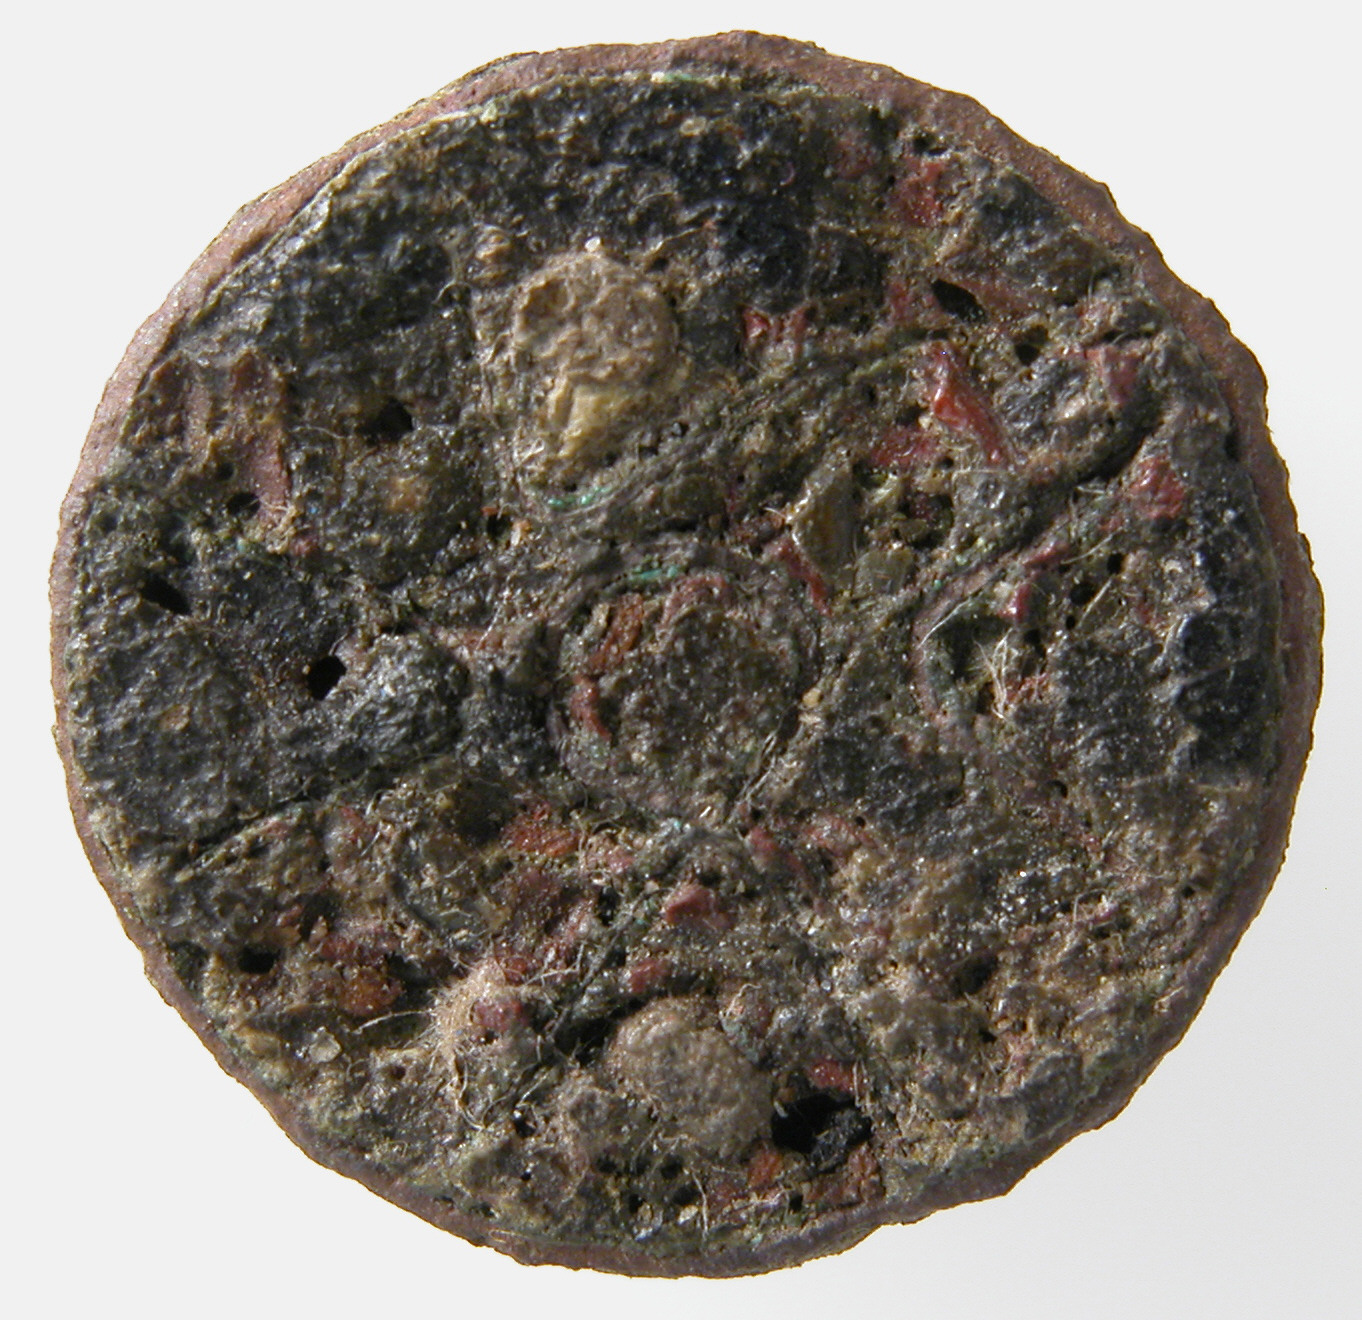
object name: brooch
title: Disk Brooch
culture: merovingian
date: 701-900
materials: copper alloy, enamel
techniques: enamel